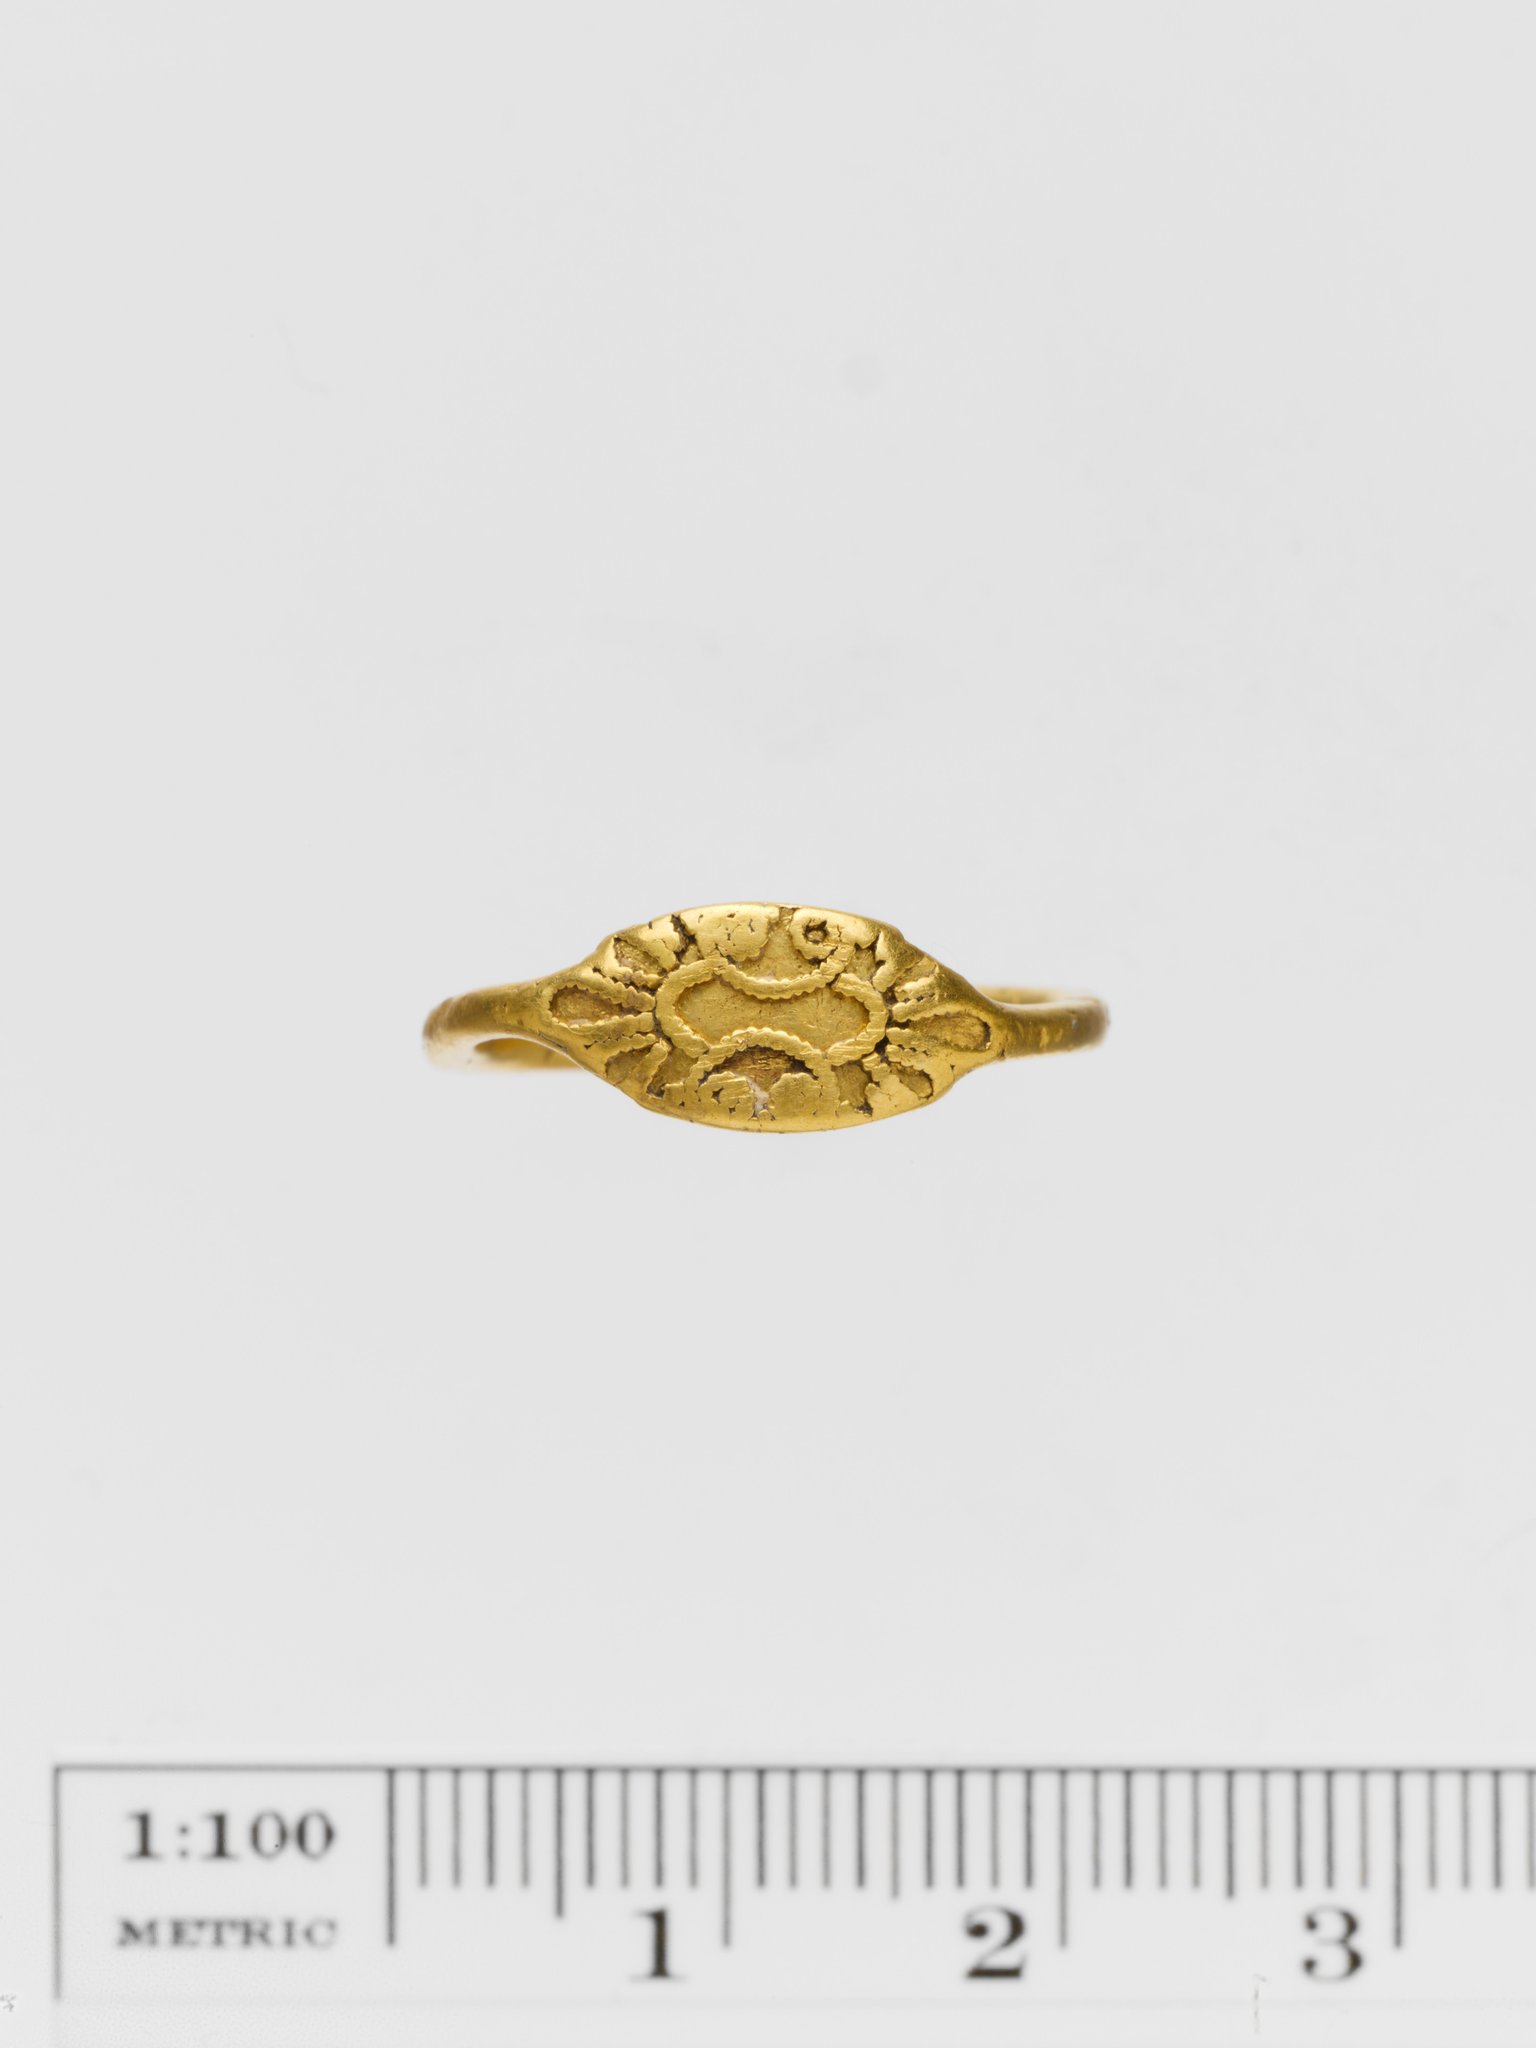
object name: ring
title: Gold ring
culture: greek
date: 600-401 BCE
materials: gold